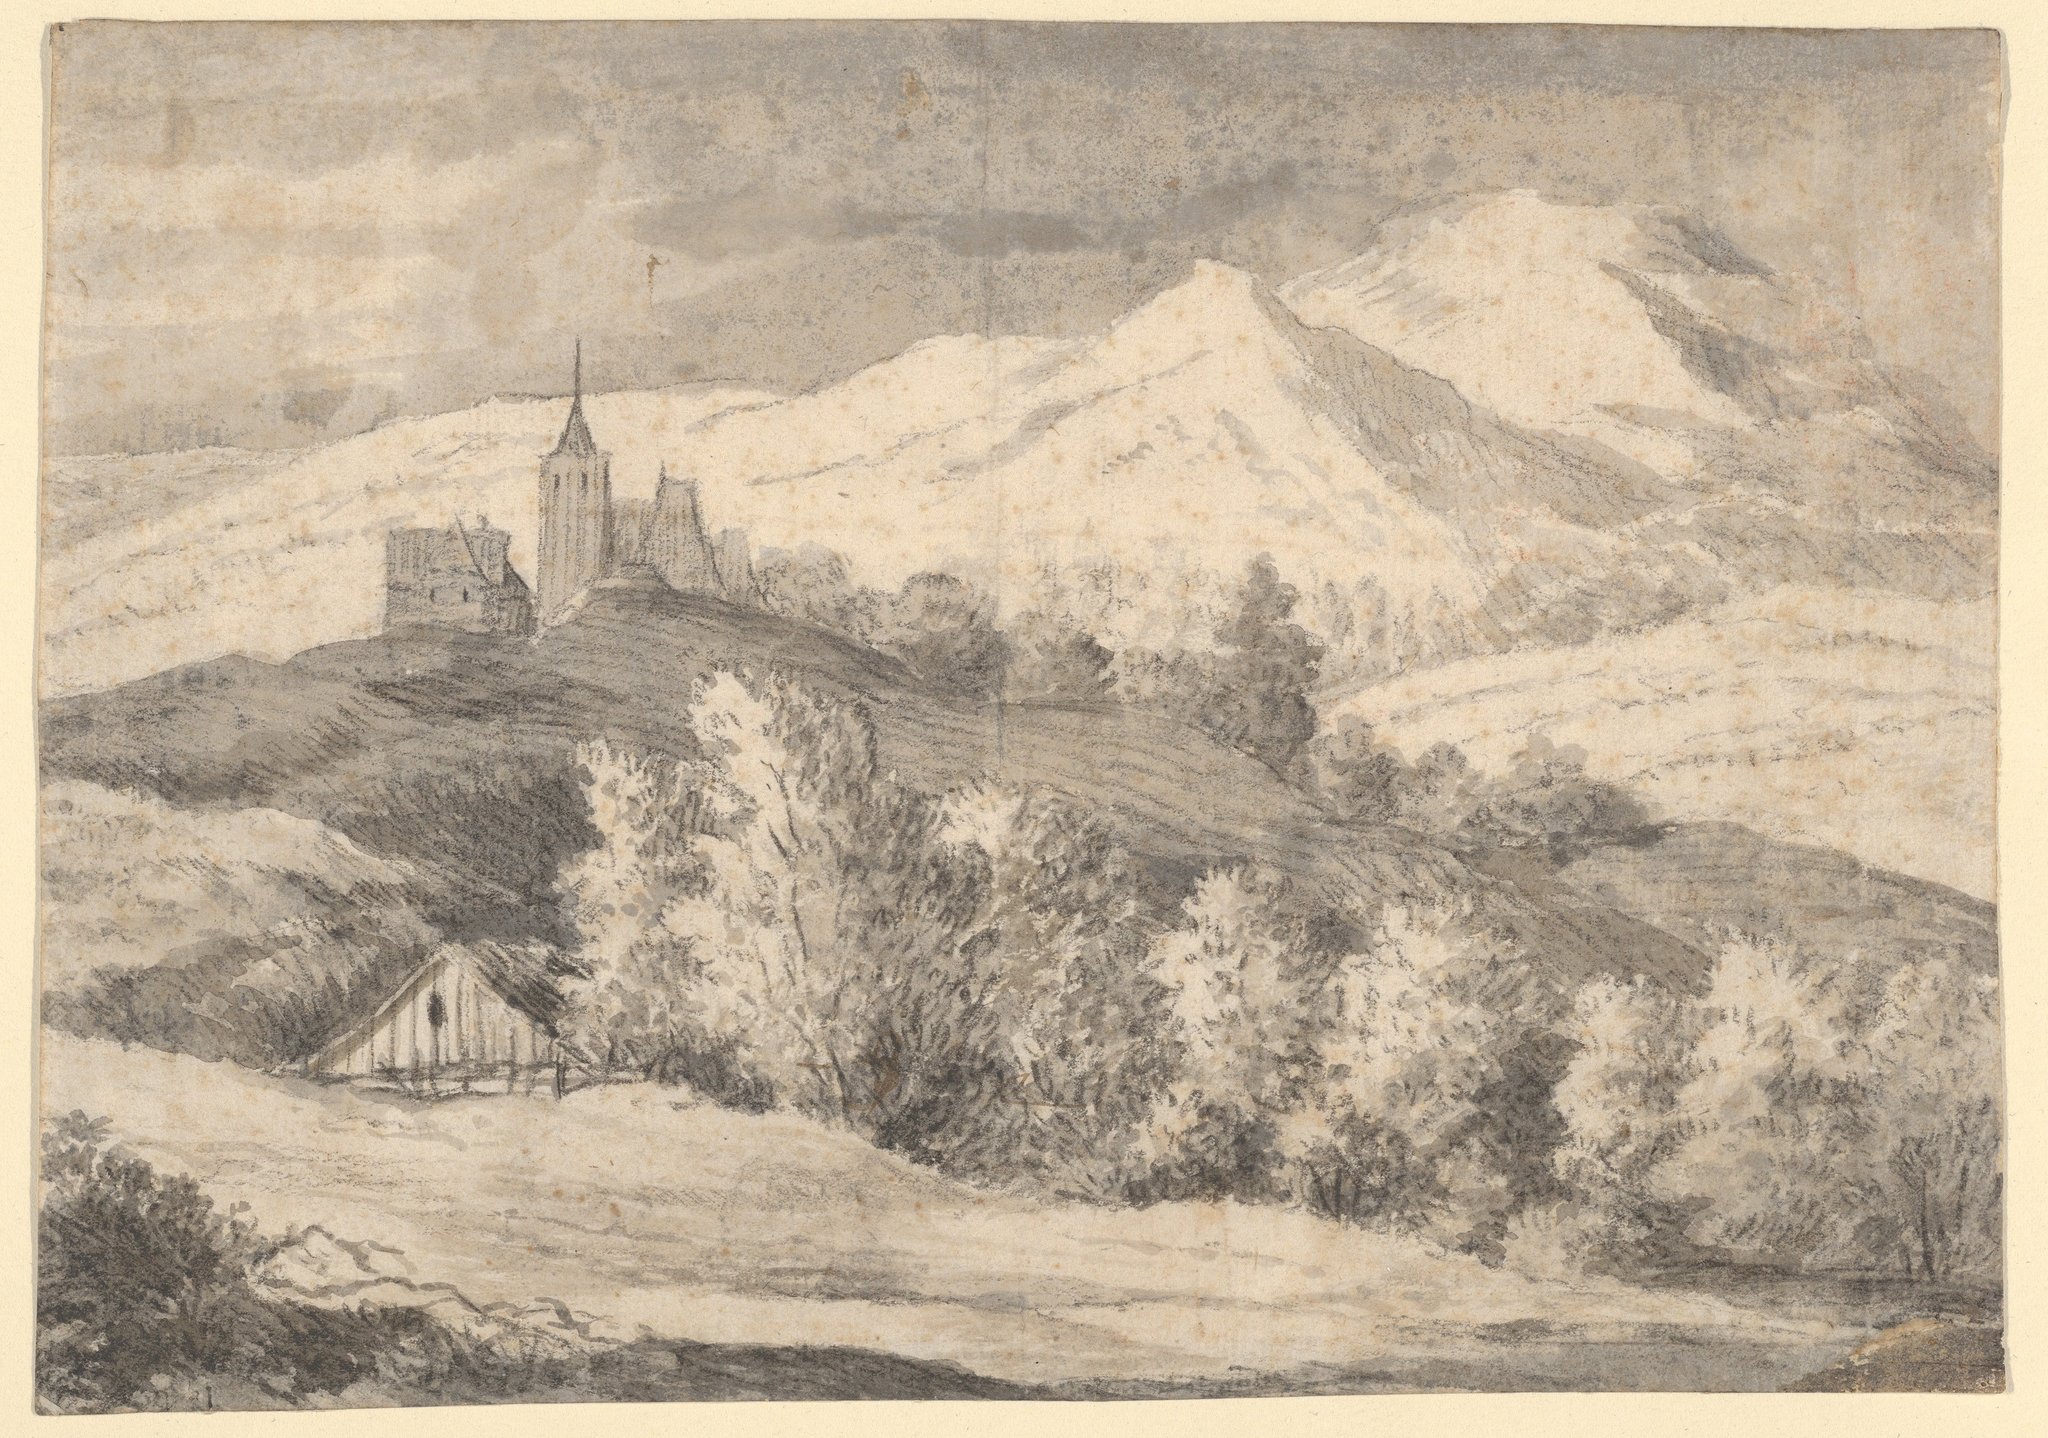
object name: drawing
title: Mountaineous Landscape with a Church and Other Buildings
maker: anonymous, dutch, 17th century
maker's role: artist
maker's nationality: dutch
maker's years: 1600-1700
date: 1601-1700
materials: chalk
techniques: brush, wash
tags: buildings,churches,mountains,landscapes,trees